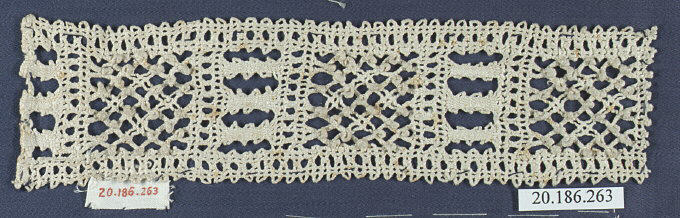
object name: insertion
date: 1501-1600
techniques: lace